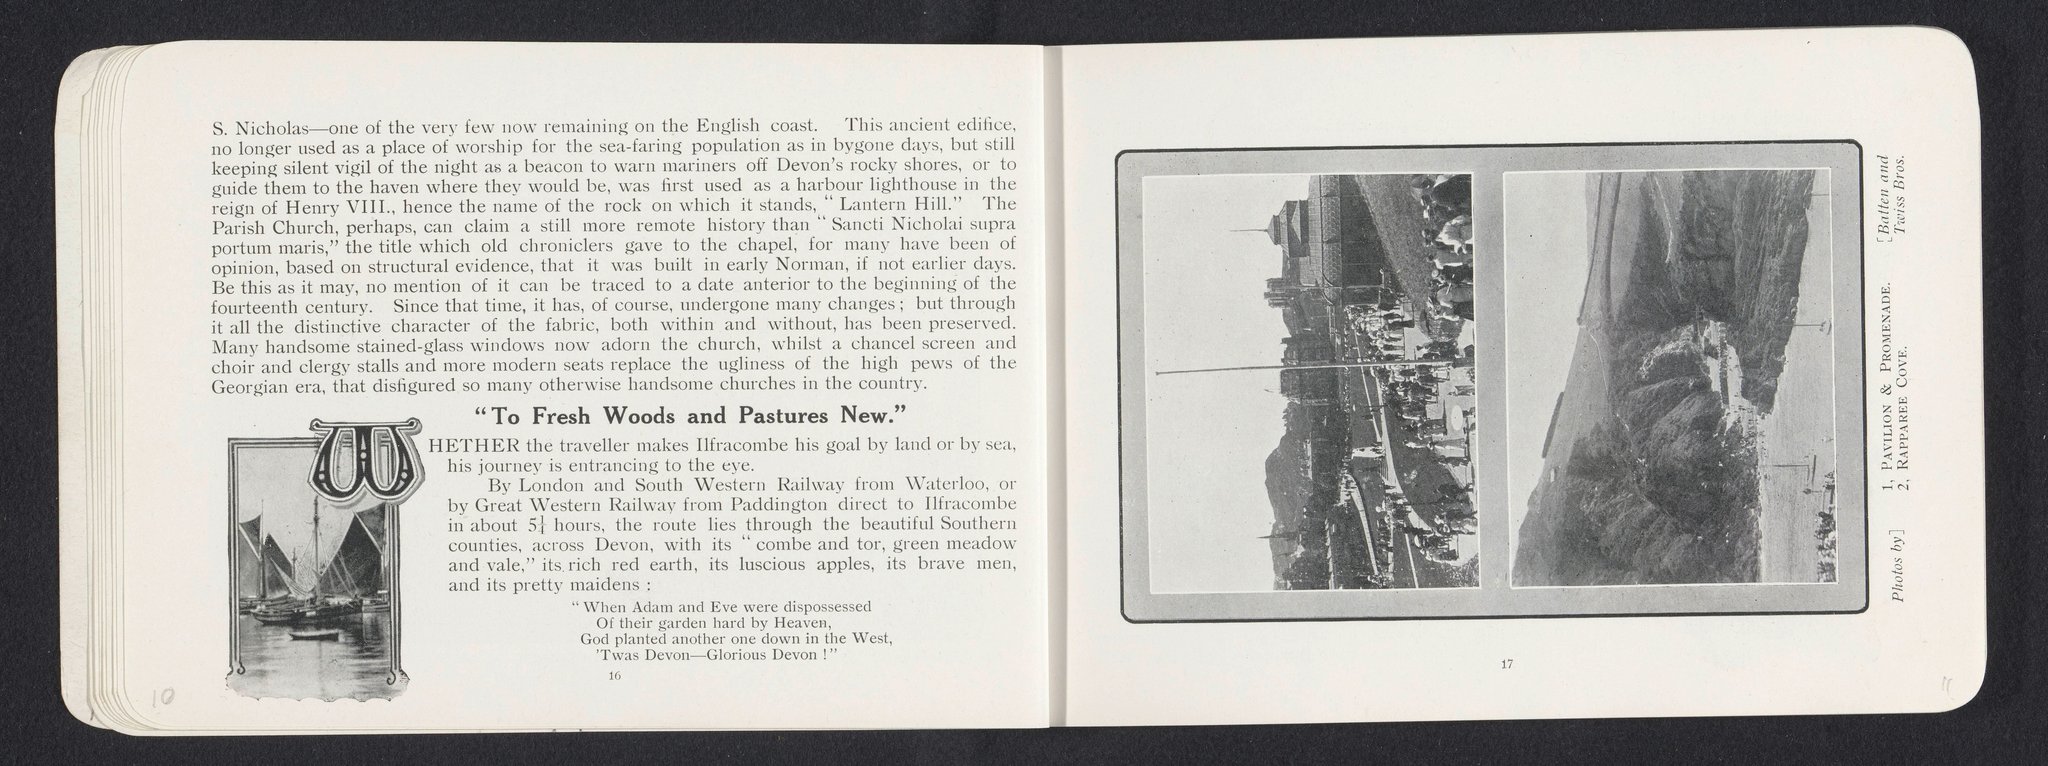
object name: page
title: Zeilboot te Ilfracombe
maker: Anonymous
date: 1900-1920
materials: paper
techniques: autotype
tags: sailing-ship, sailing-boat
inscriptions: inscription: ‘S. Nicholas (...) Glorious Devon !"’